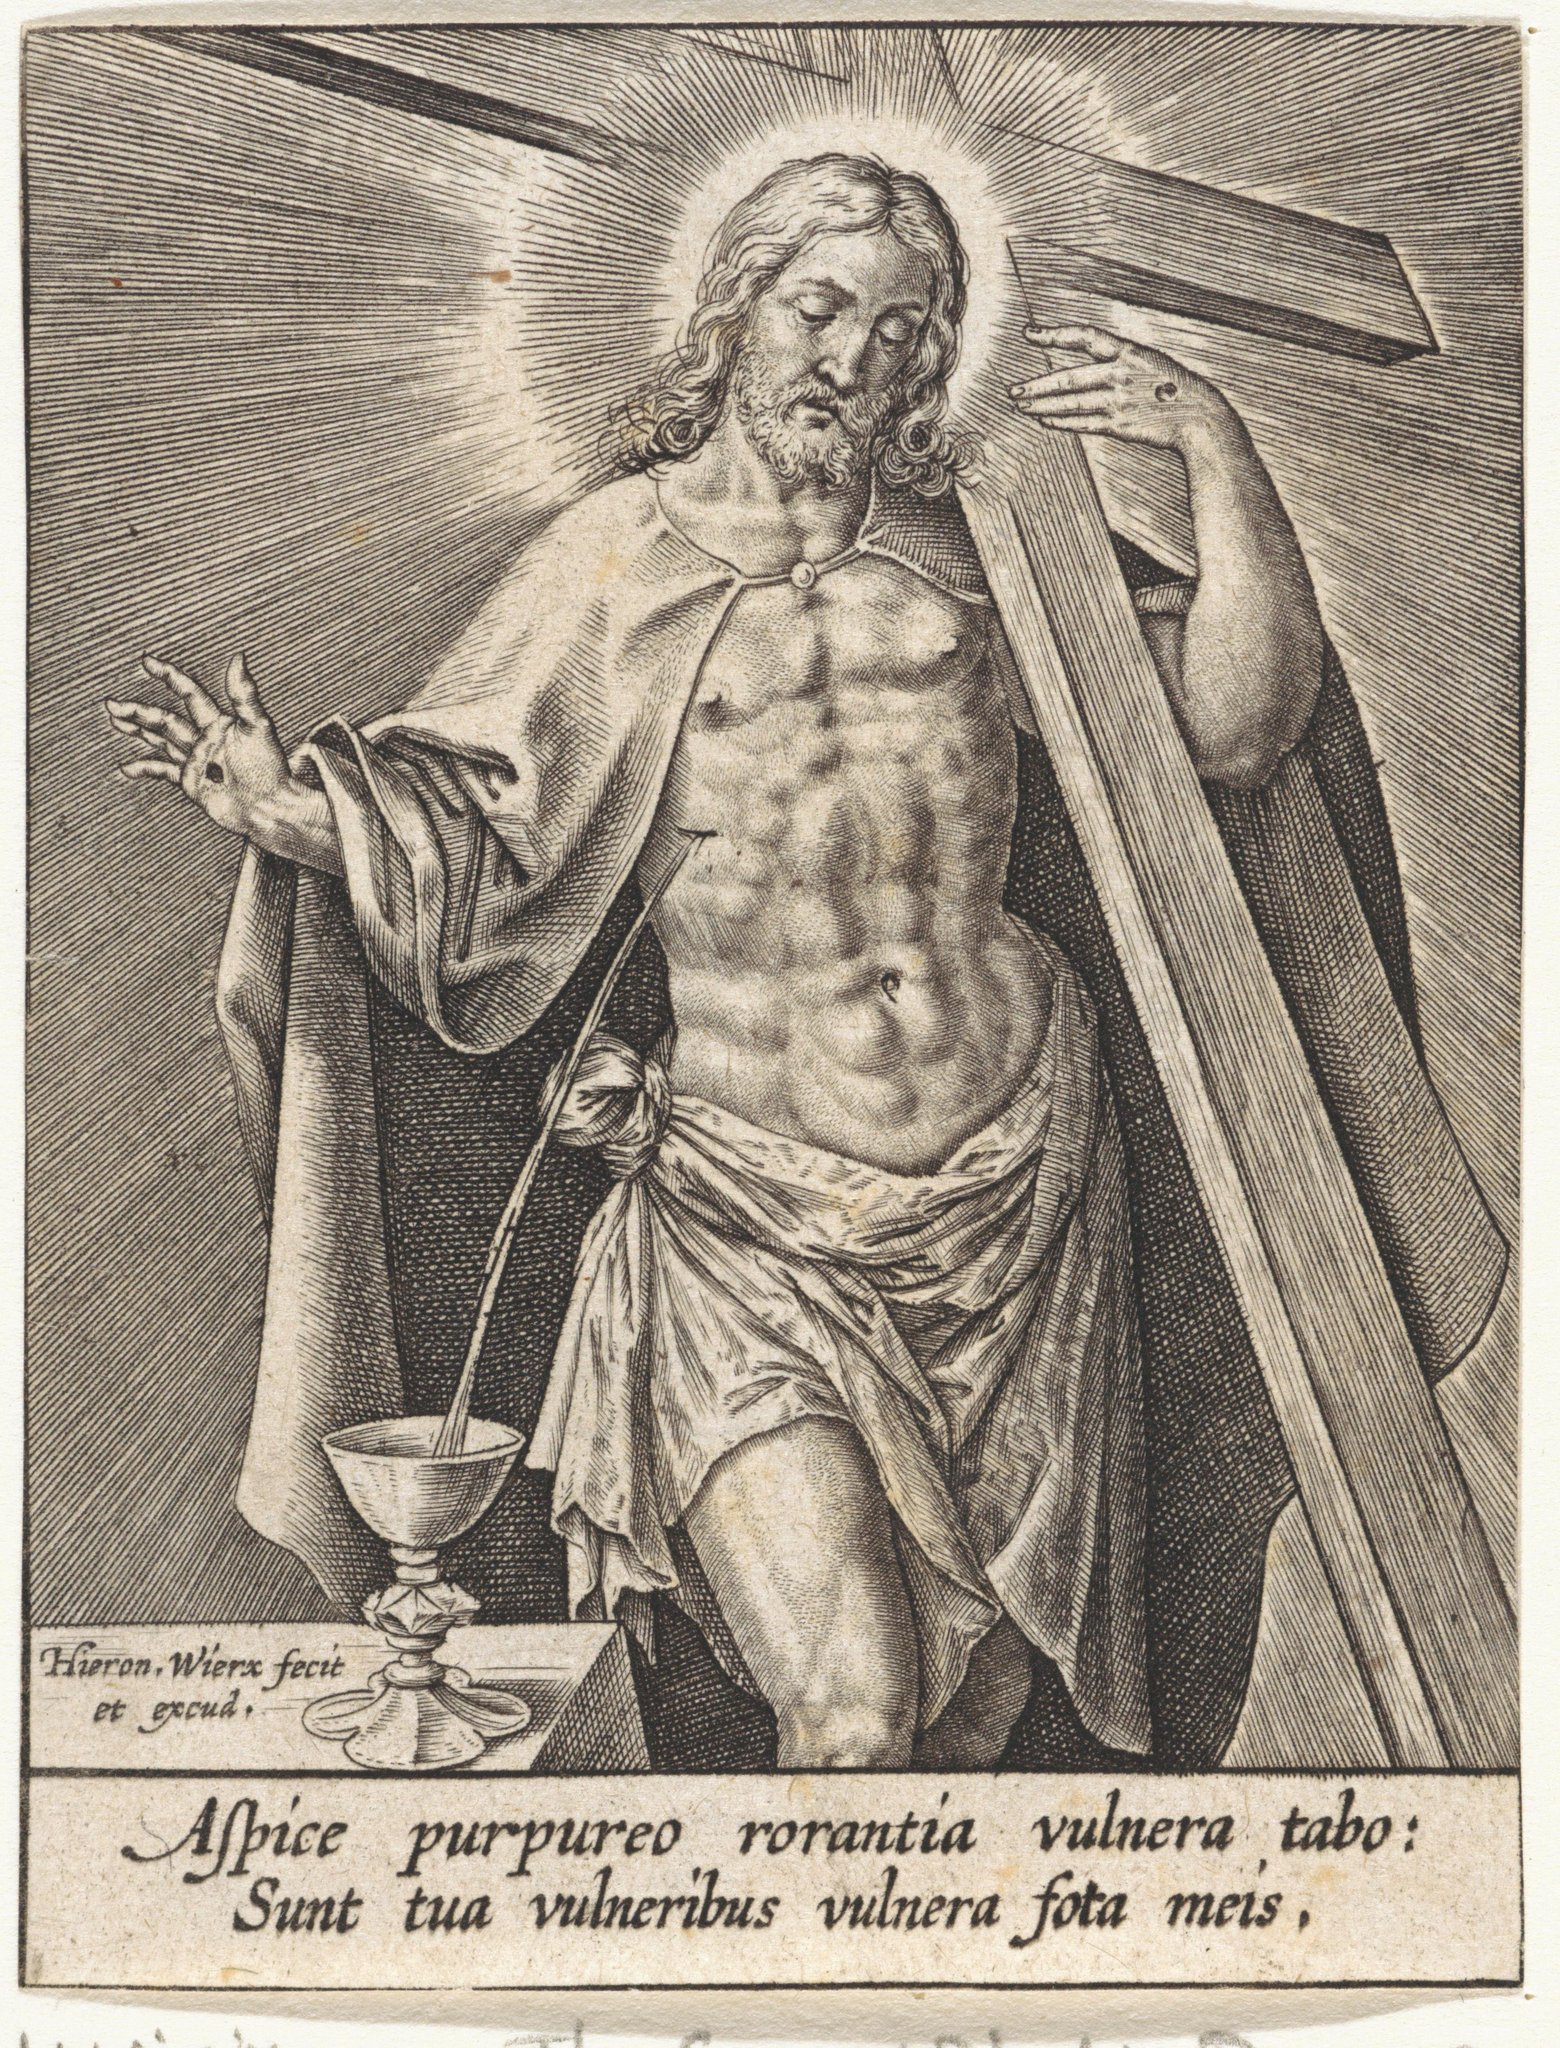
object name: print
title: Christus met zijn kruis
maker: hieronymus wierix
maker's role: draughtsman, print maker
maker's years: 1553-1619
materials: paper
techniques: engraving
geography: antwerp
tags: types of adult christ (alone), blood spouting from christ's wounds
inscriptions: collector's mark: Lugt 2228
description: Christus draagt zijn kruis op zijn schouder. Uit de wond in zijn zijde stroomt het bloed in een kelk. In de marge een tweeregelig onderschrift in het Latijn.